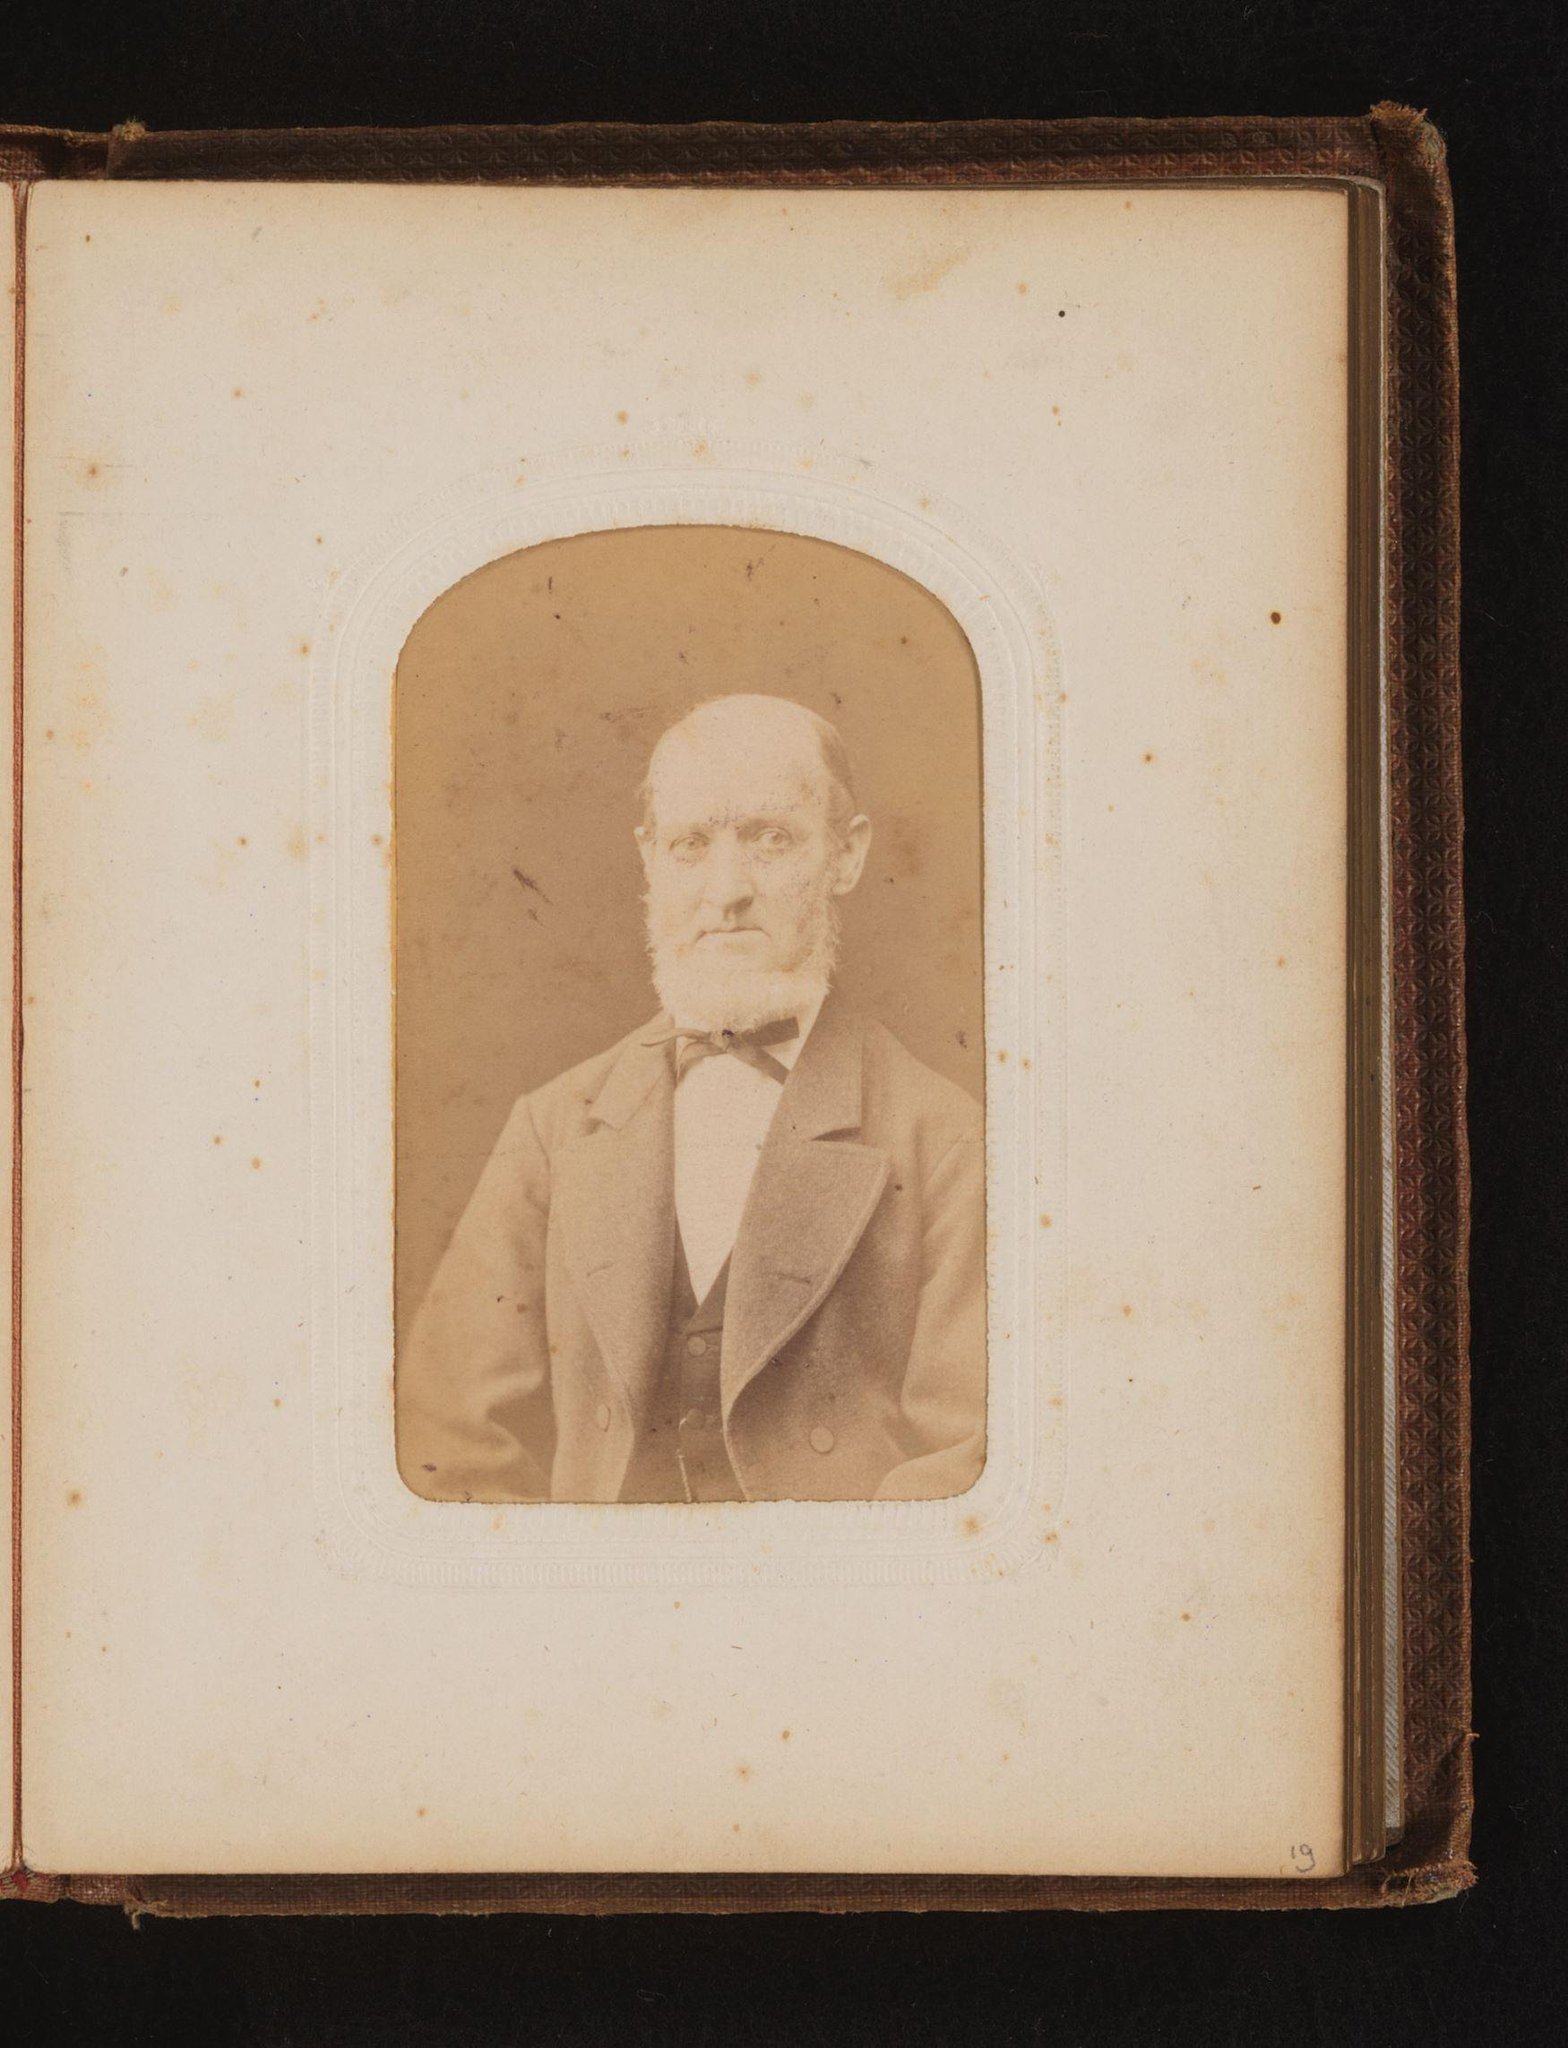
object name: photograph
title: Portret van een man met baard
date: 1860-1900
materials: cardboard, photographic support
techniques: albumen print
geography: frankfurt am main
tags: historical persons, beard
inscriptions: inscription: ‘Photographisches/ ATELIER/ STRAUB & KÜHN/ Frankfurt a/M/ Zeil 70./ Haus Mozart./ Die Platte wird zur Nachbestellung/ aufbewahrt.’